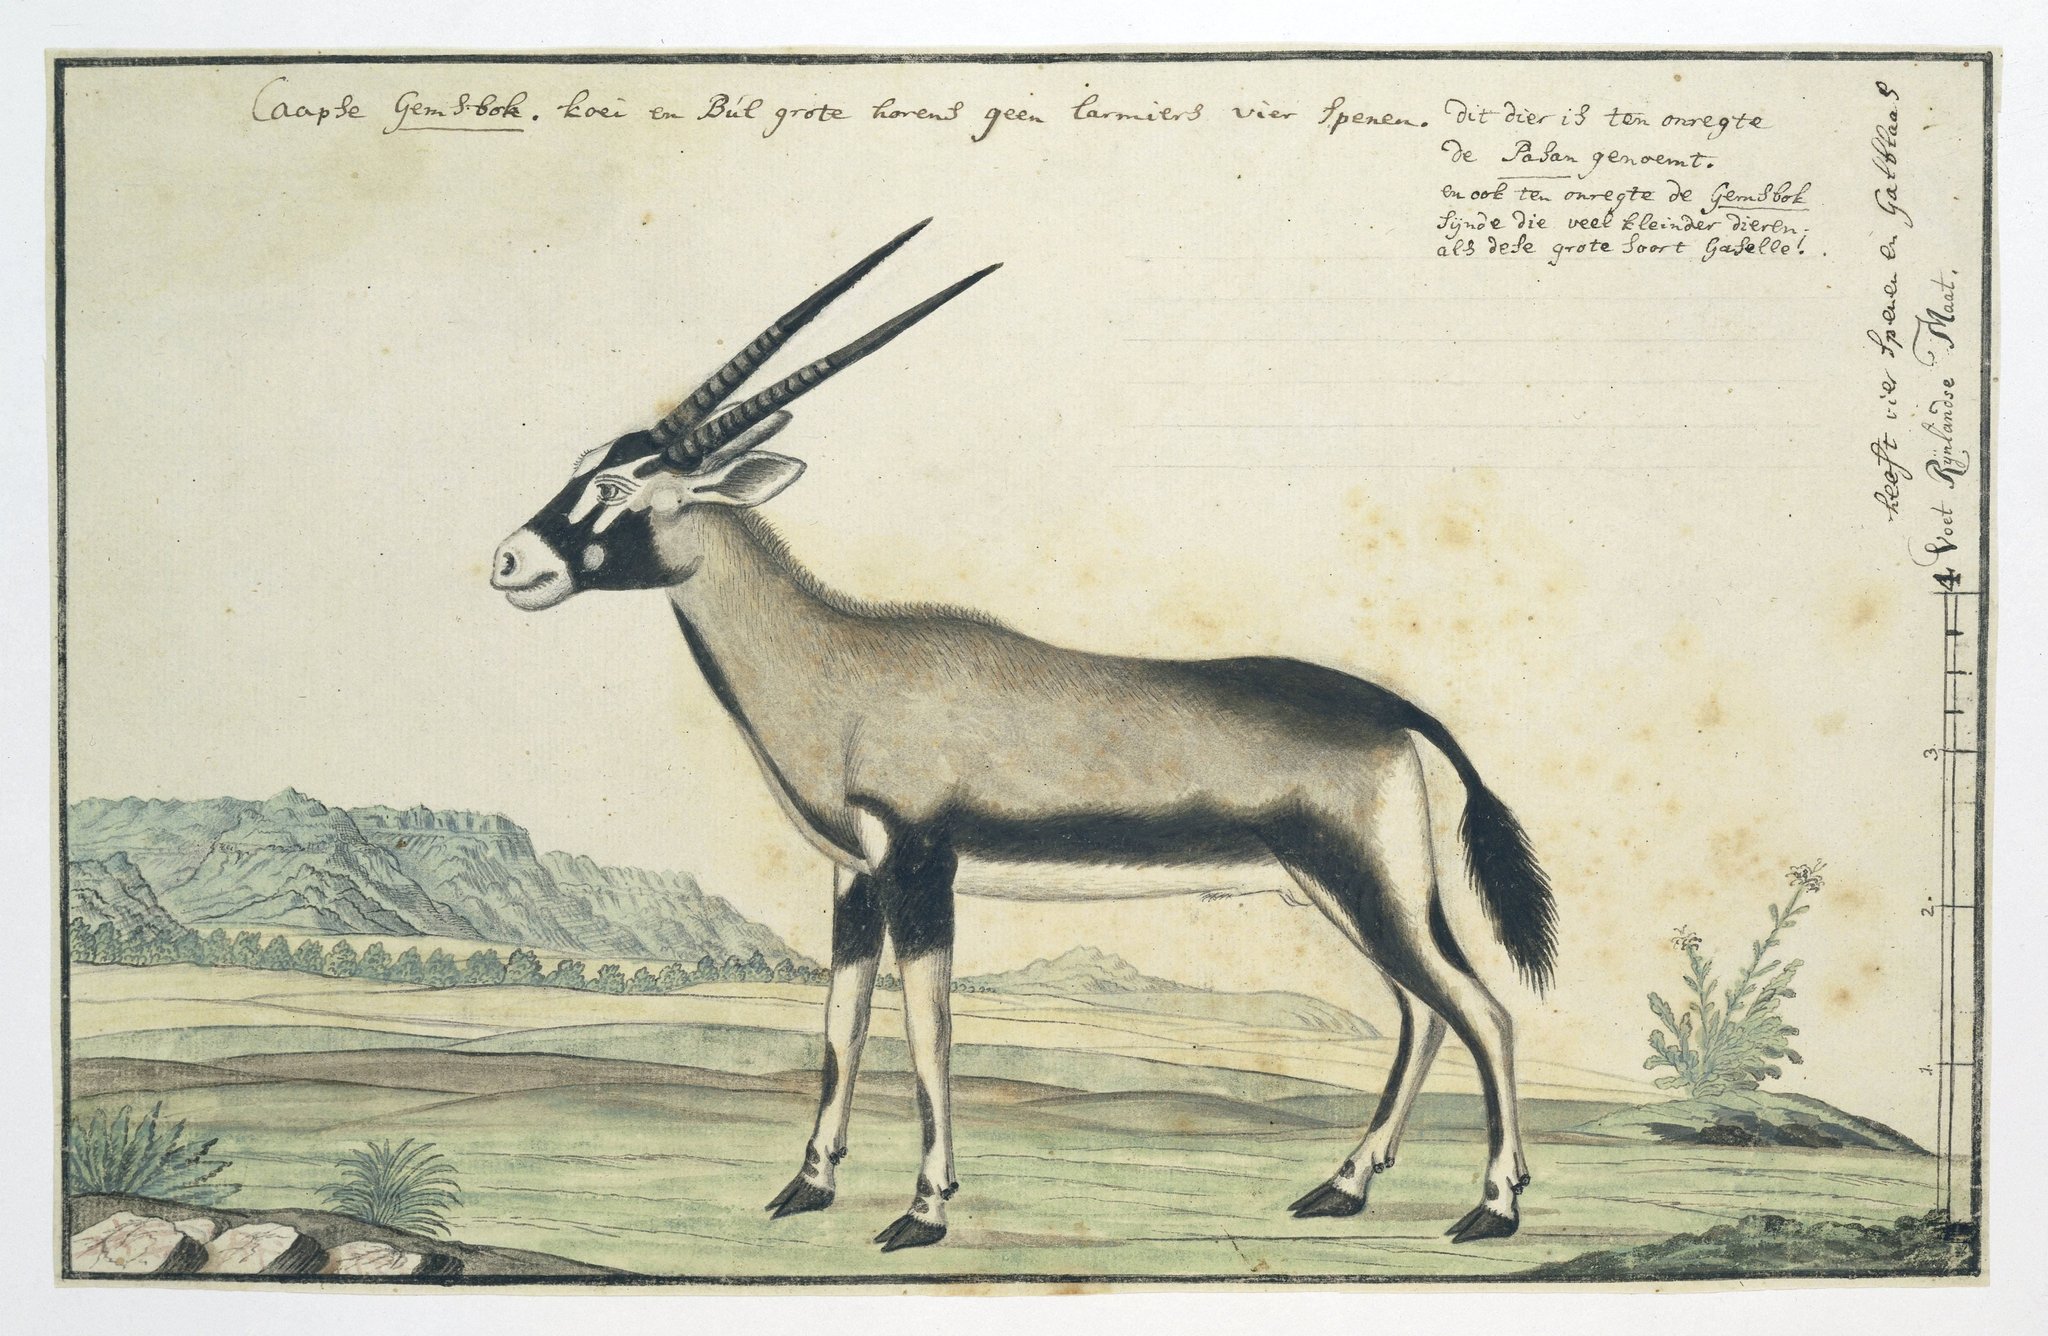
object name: drawing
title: Oryx gazella (Gemsbok)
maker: robert jacob gordon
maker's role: draughtsman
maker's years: 1743-1795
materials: chalk, ink, paper, pencil, watercolor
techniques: brush, pen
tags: animals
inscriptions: annotation: ‘Caapse Gemsbok [onderstreept]. koei en bul grote horens geen larmiers vier spenen. ...’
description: Volgens Gordon ten onrechte Kaapse gemsbok genoemd; met schaalverdeling in Rijnlandse maat.